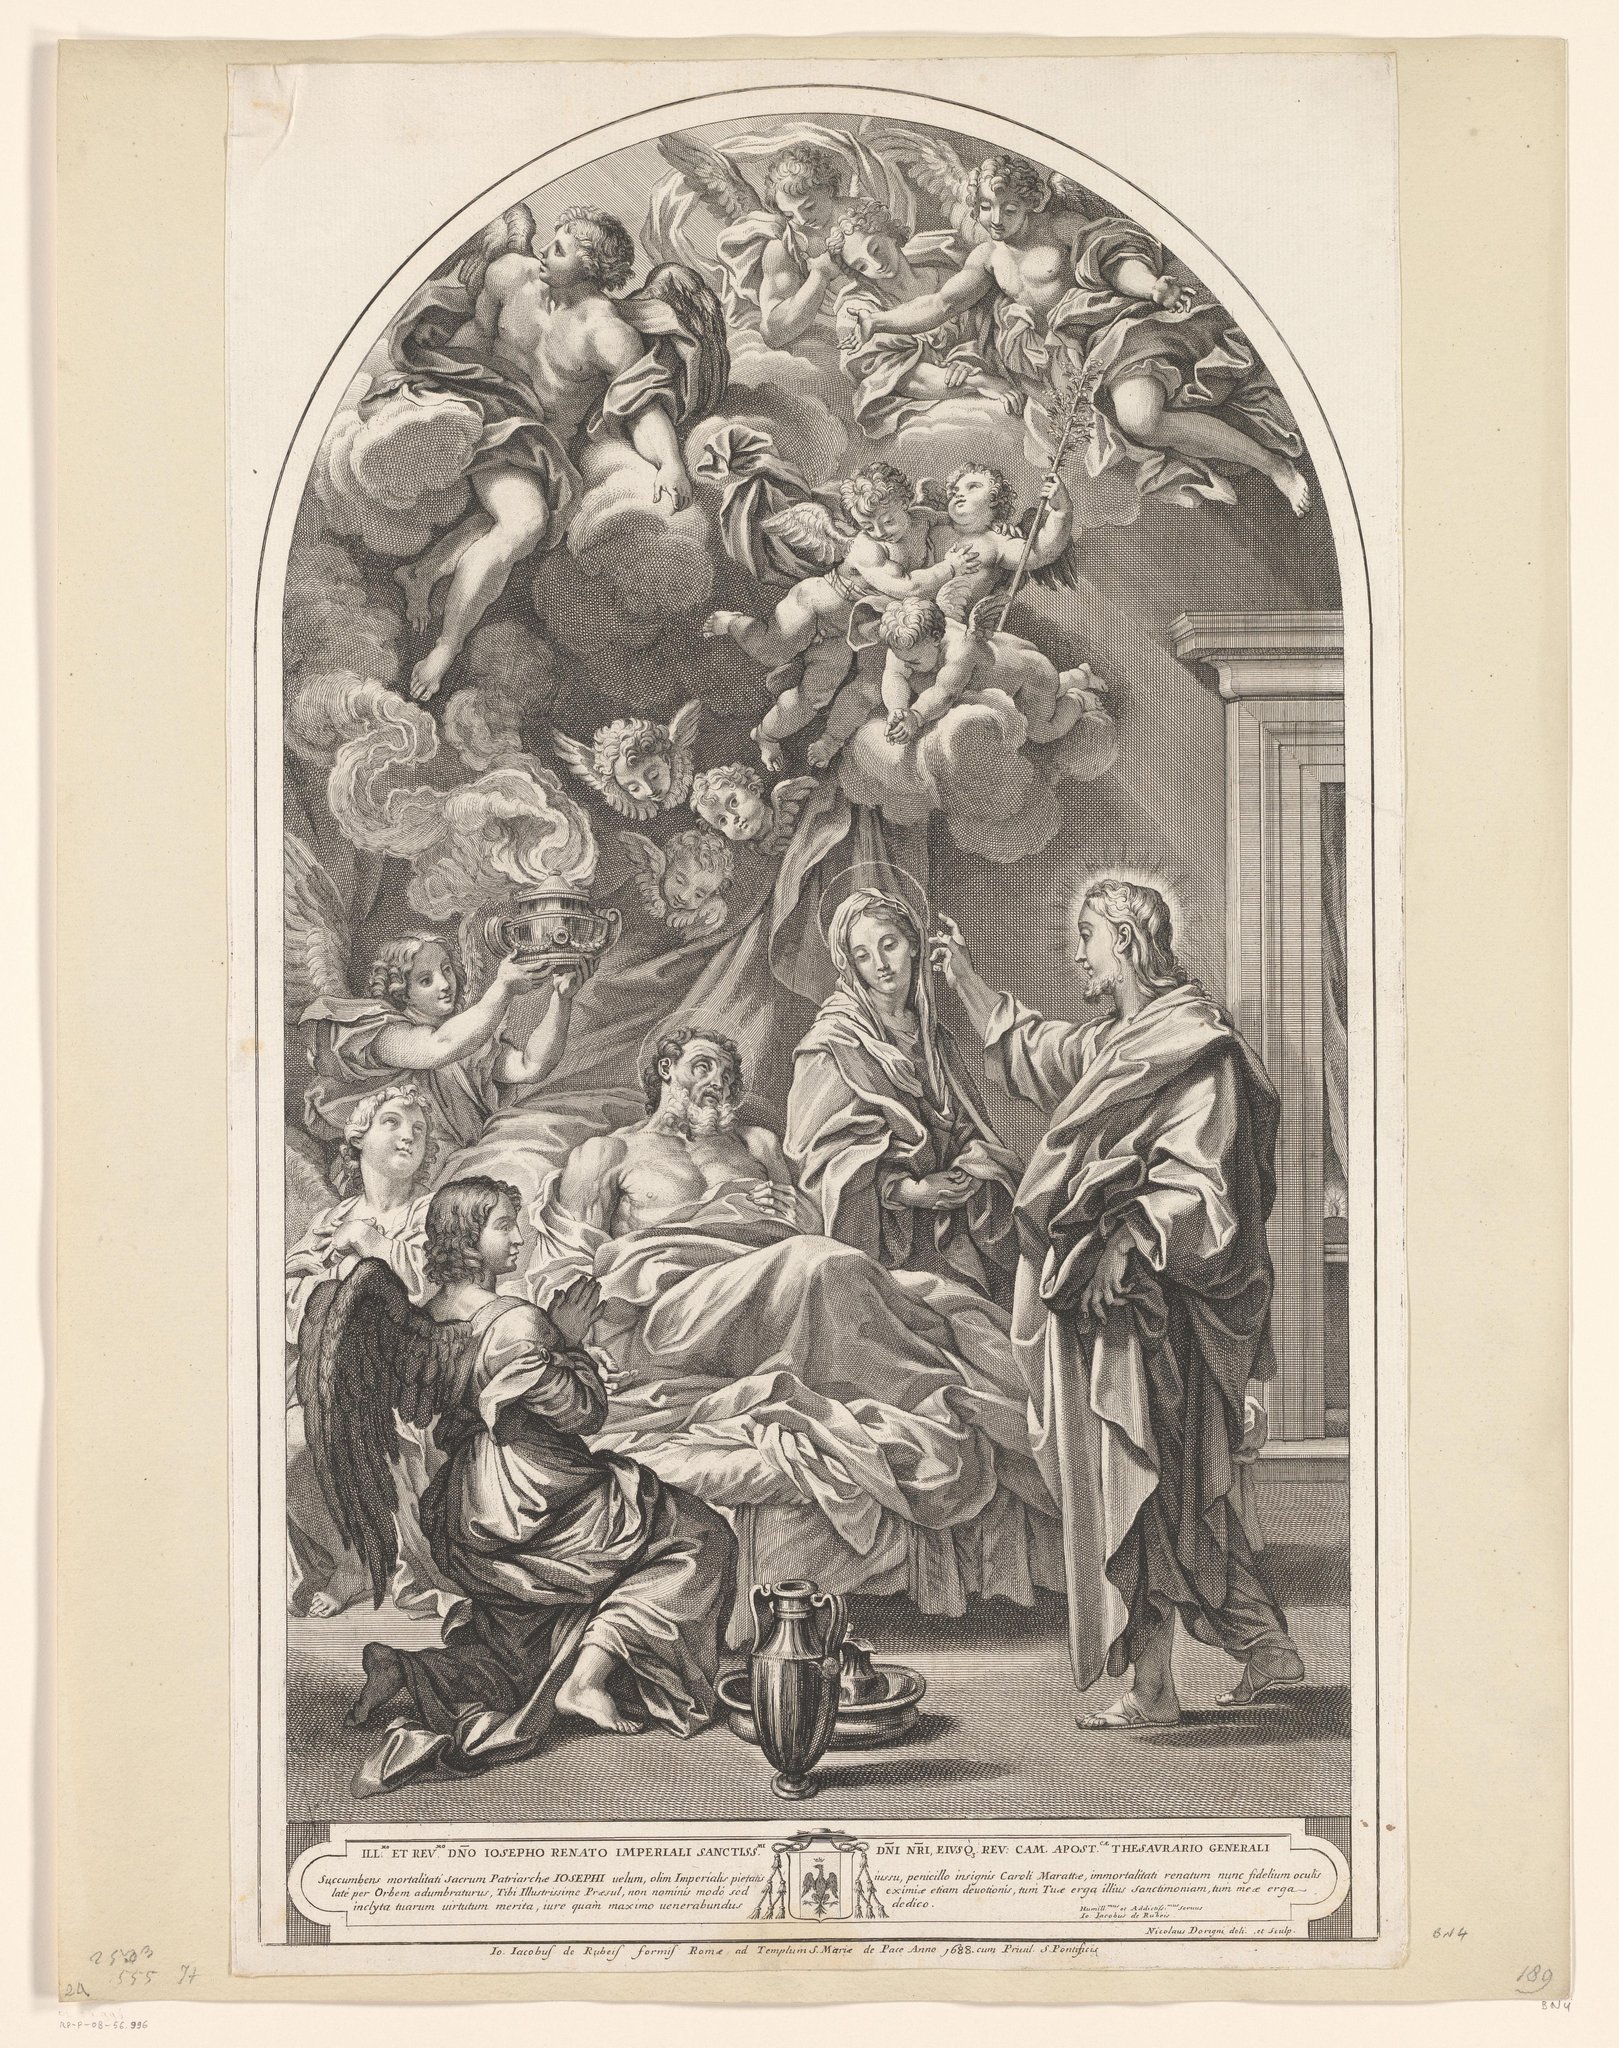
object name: print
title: Dood van Jozef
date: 1688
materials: paper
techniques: engraving, etching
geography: rome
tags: joseph's death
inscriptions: collector's mark: Lugt 240